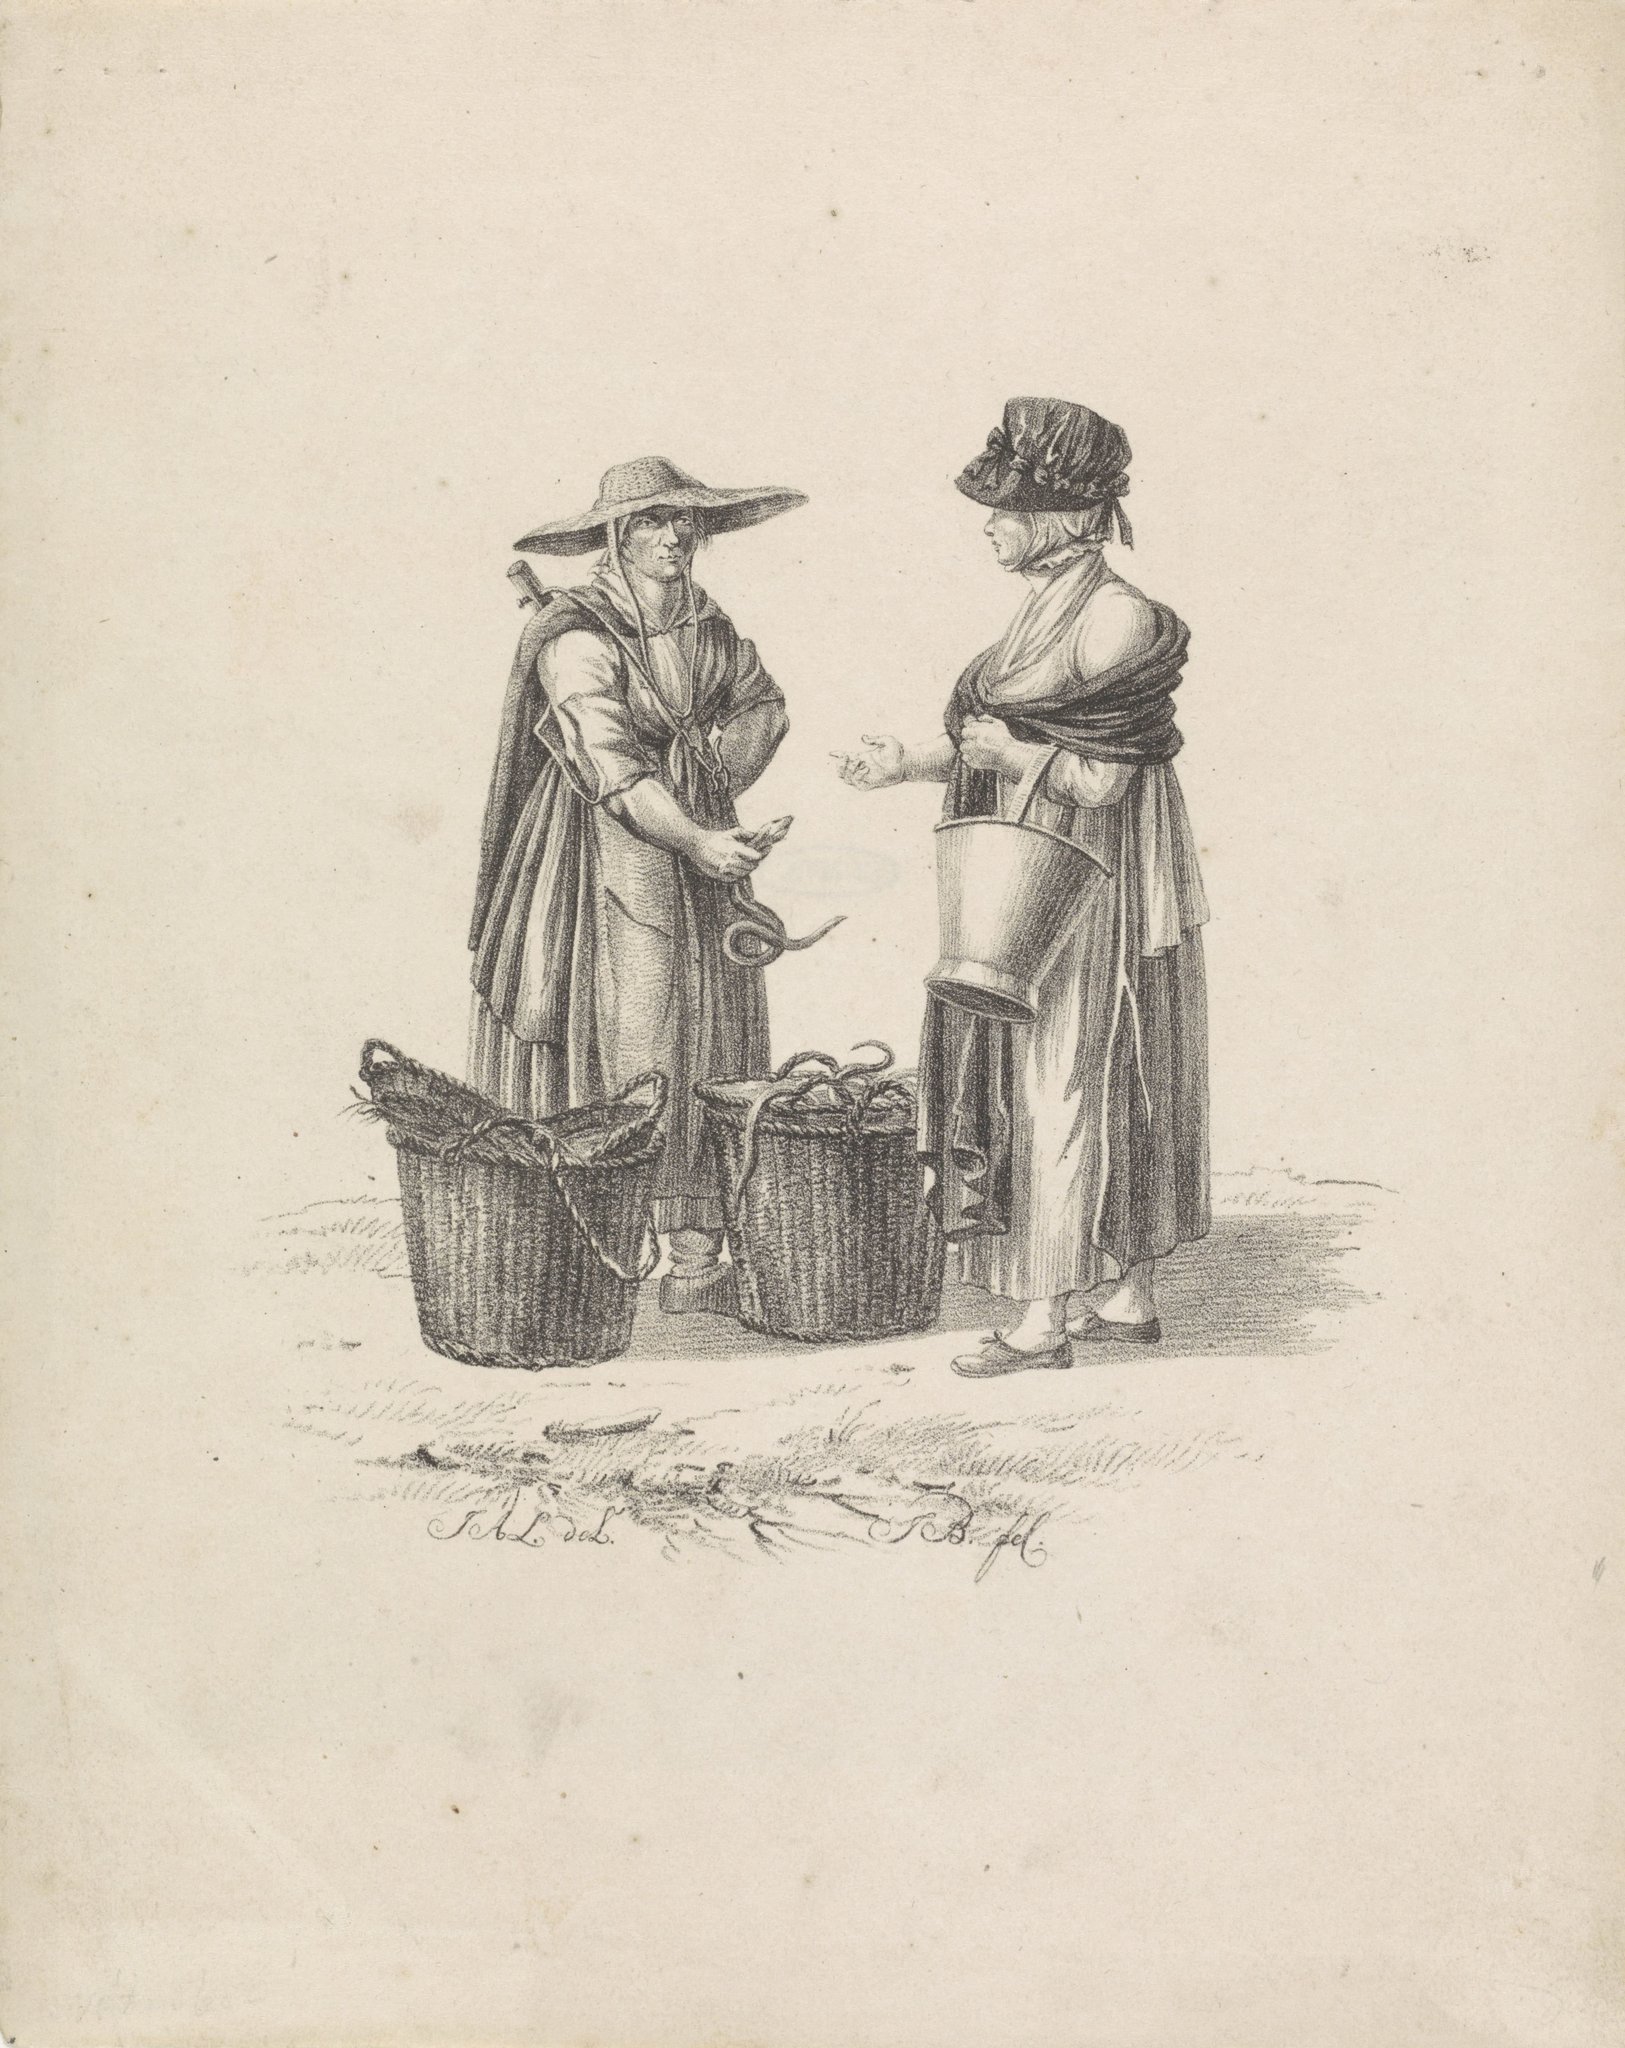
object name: print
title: Palingverkoopster met klant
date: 1820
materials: paper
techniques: lithograph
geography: netherlands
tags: buying and selling, eels: eel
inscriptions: collector's mark: Lugt 2228, collector's mark: Lugt 2760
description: Een palingverkoopster staat achter twee manden met palingen. In haar rechterhand heeft zij een paling vast. De vrouw tegenover haar draagt een mand aan haar linkerarm en strekt haar rechterhand uit naar de paling.